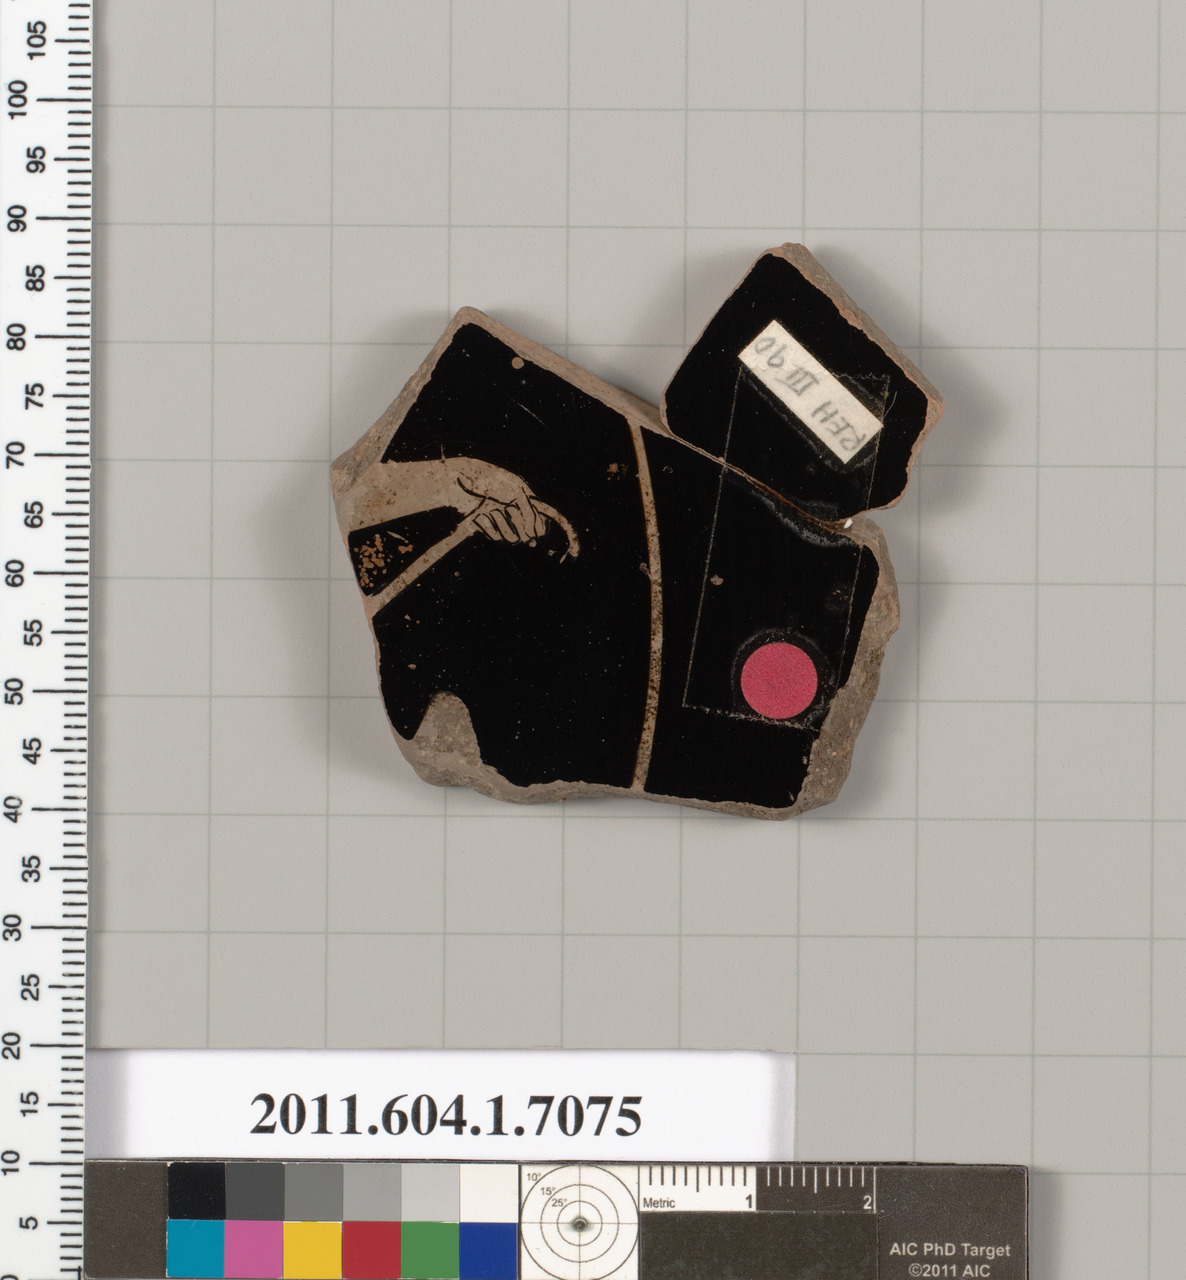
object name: kylix fragment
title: Terracotta fragment of a kylix (drinking cup)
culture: greek, attic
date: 500-480 BCE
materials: terracotta